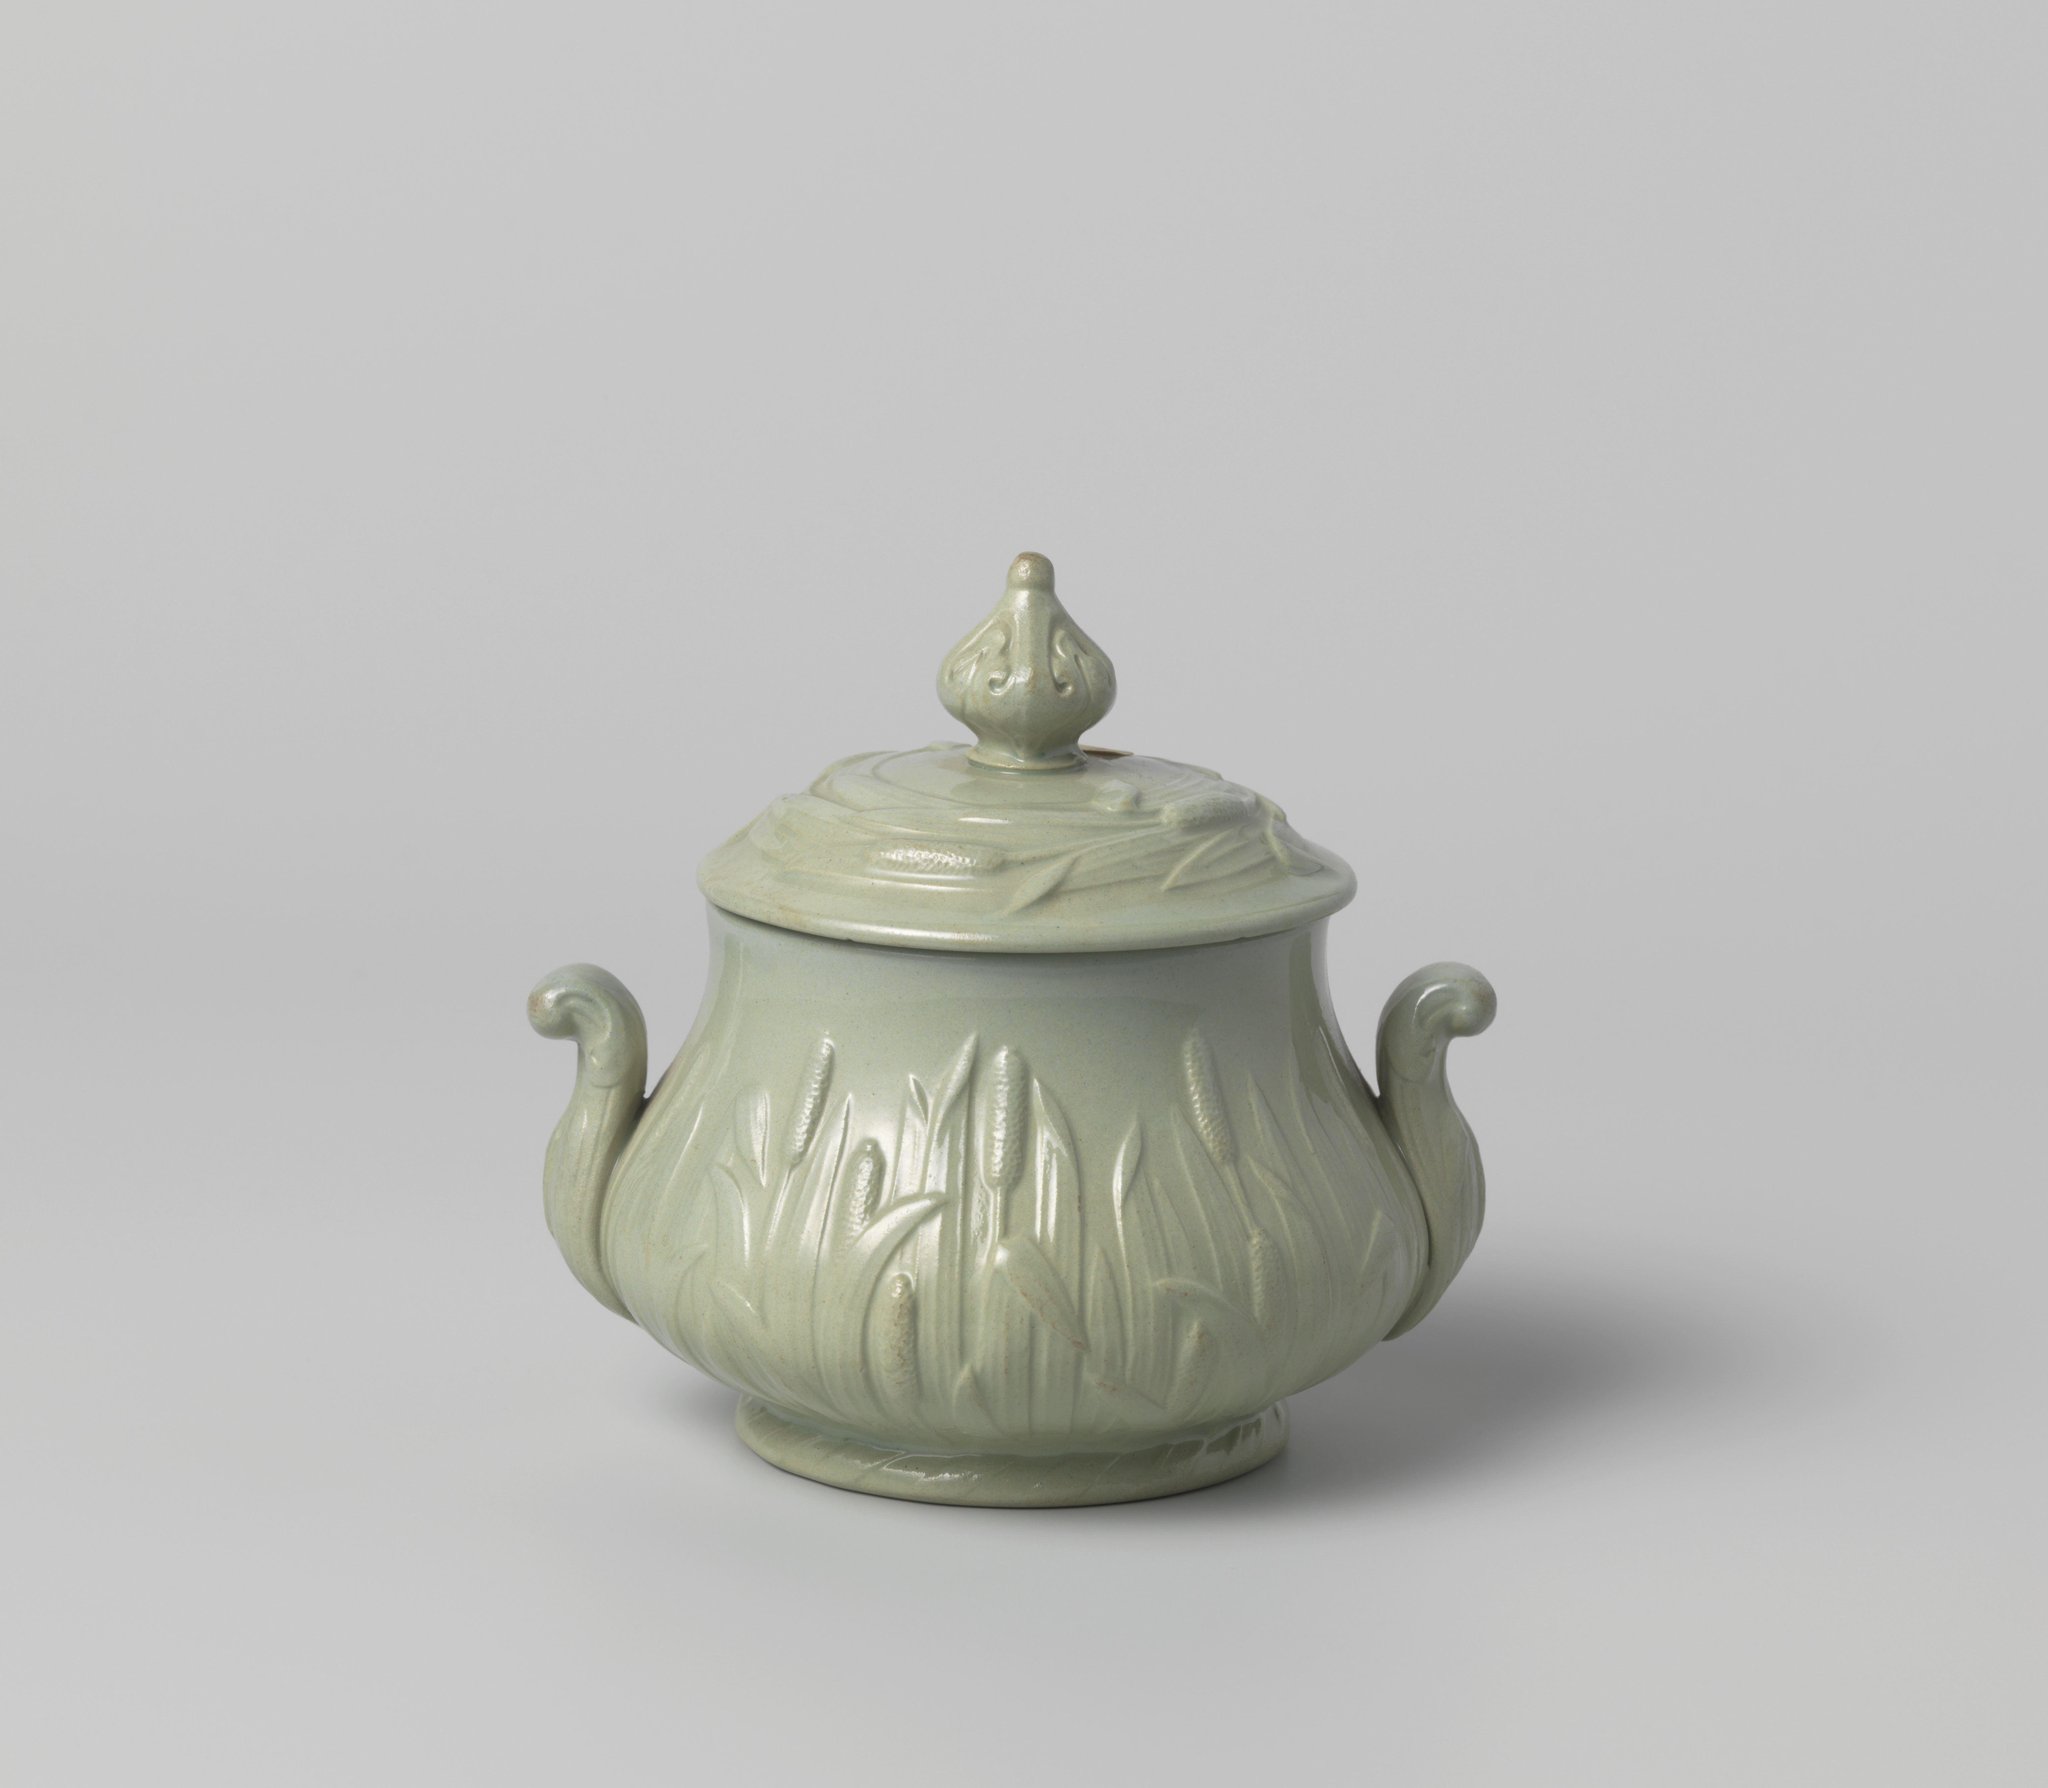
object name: sugar box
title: Suikerpot met reliëfversiering van lisdodden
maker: petrus regout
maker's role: plateelbakker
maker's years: 1801-1879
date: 1870-1890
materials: creamware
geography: maastricht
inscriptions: mark: ‘P. REGOUT // MAASTRICHT en 4’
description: Suikerpot van aardewerk, celadonkleurig. De wanden in reliëf versierd met lisdodden, die gedeeltelijk over de twee s-vormige oren doorlopen. Het gewelfde deksel is in reliëf gedecoreerd met een krans van lisdodden, en wordt bekroond door een ui-vormige knop, waarop in reliëf franse lelies.